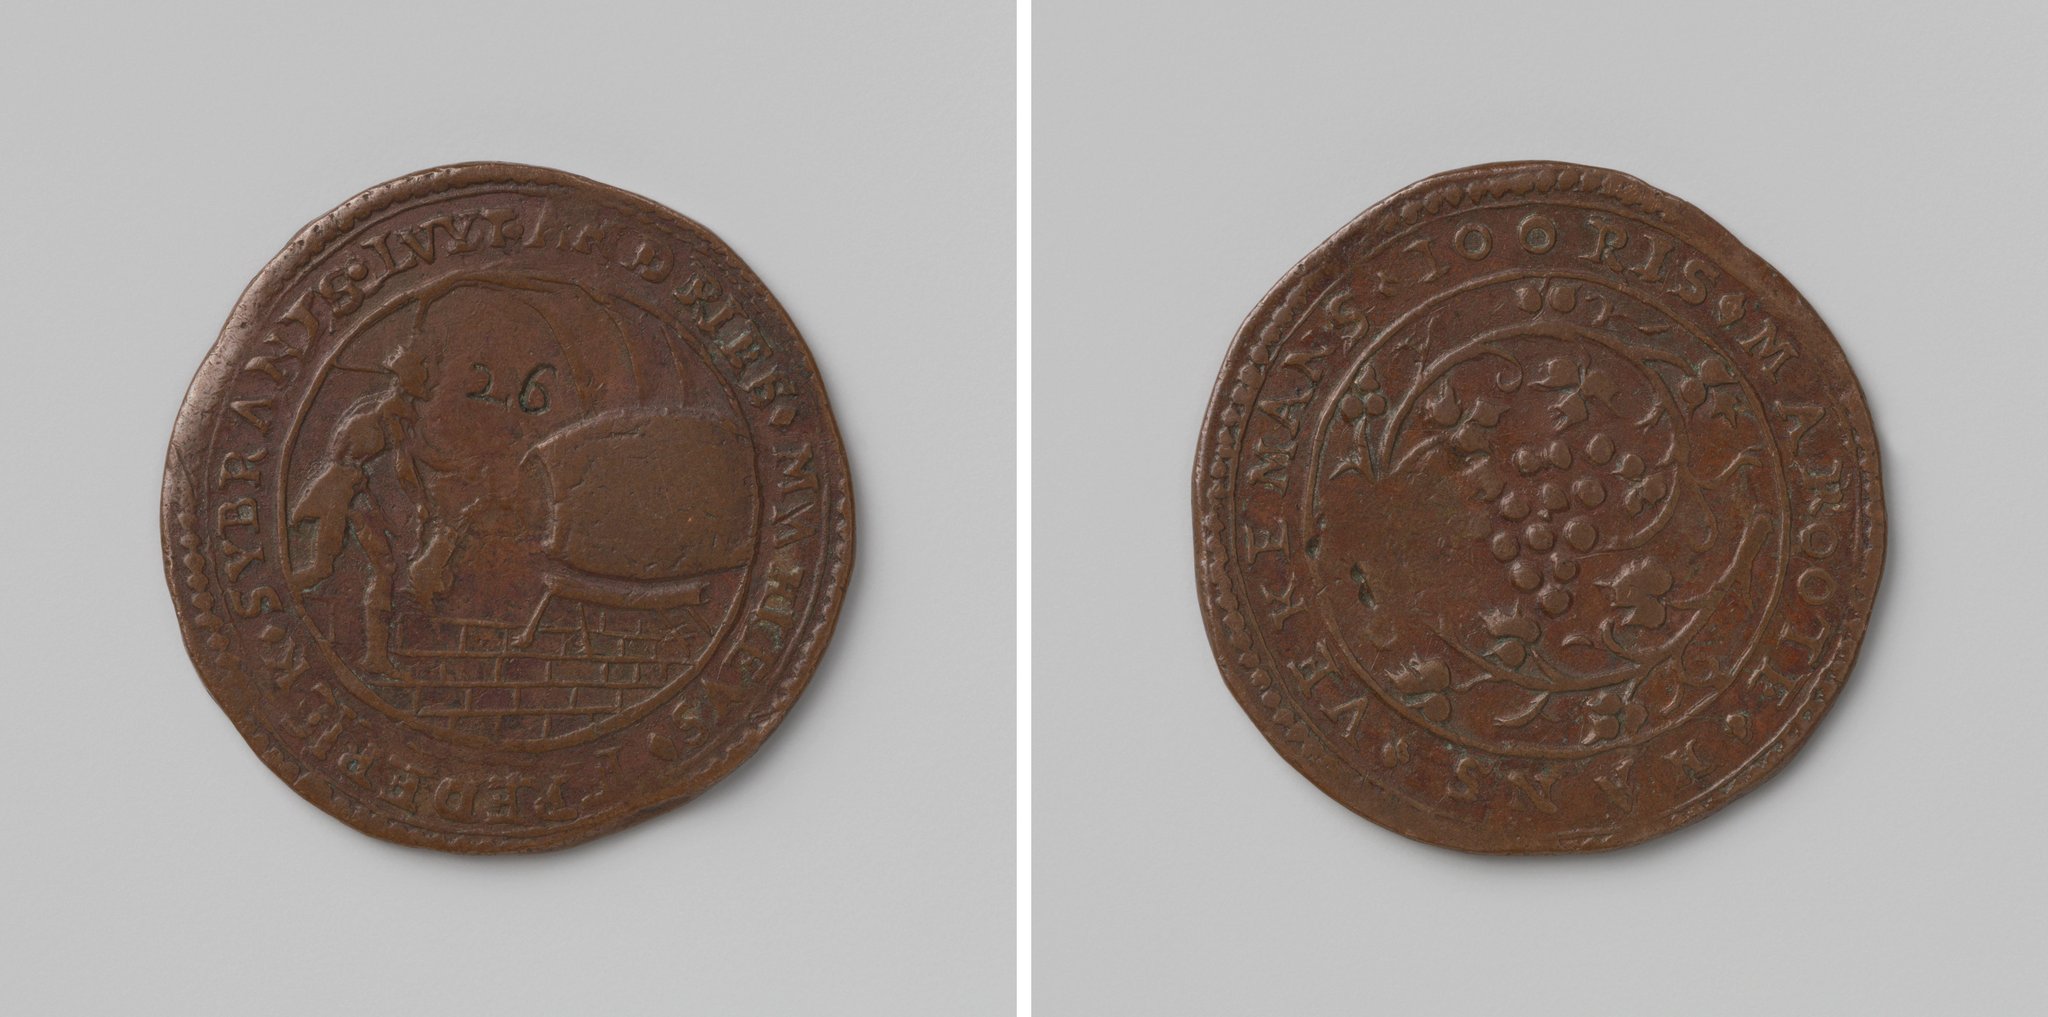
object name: medal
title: Tappersgilde uit België, gildepenning met no. 26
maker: Anonymous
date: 1400-1885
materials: copper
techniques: engraving, striking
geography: belgium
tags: belgium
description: Koperen penning. Voorzijde: man met kruik in rechterhand, bezig met tappen uit vat in een gewelfde kelder; daarboven: cijfer 26 binnen omschrift. Keerzijde: druivetros aan wijnrank binnen omschrift.